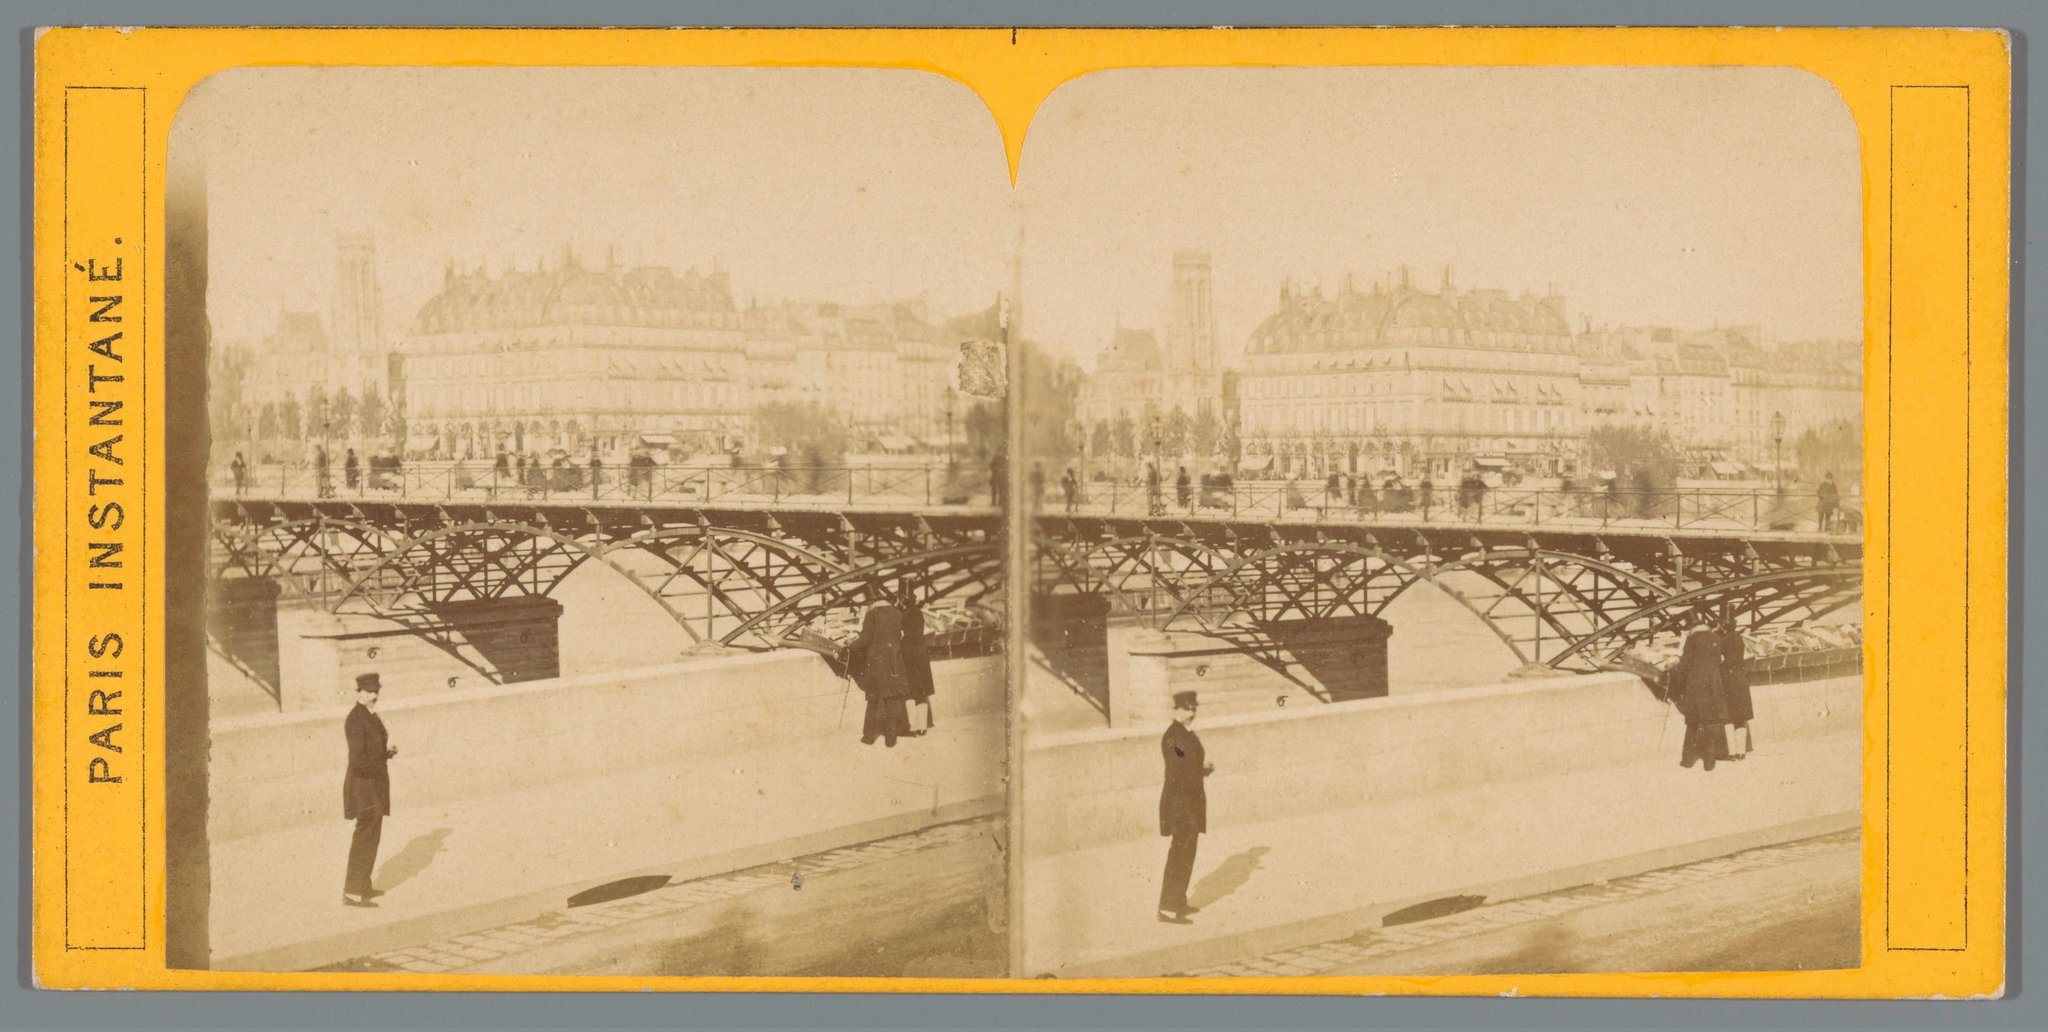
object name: stereograph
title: Paris Instantané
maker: adolphe block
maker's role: publisher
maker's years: 1829-1918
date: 1850-1880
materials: cardboard, photographic support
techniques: albumen print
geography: paris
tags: bridge in city across river, canal, etc.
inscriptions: number: ‘No 269’